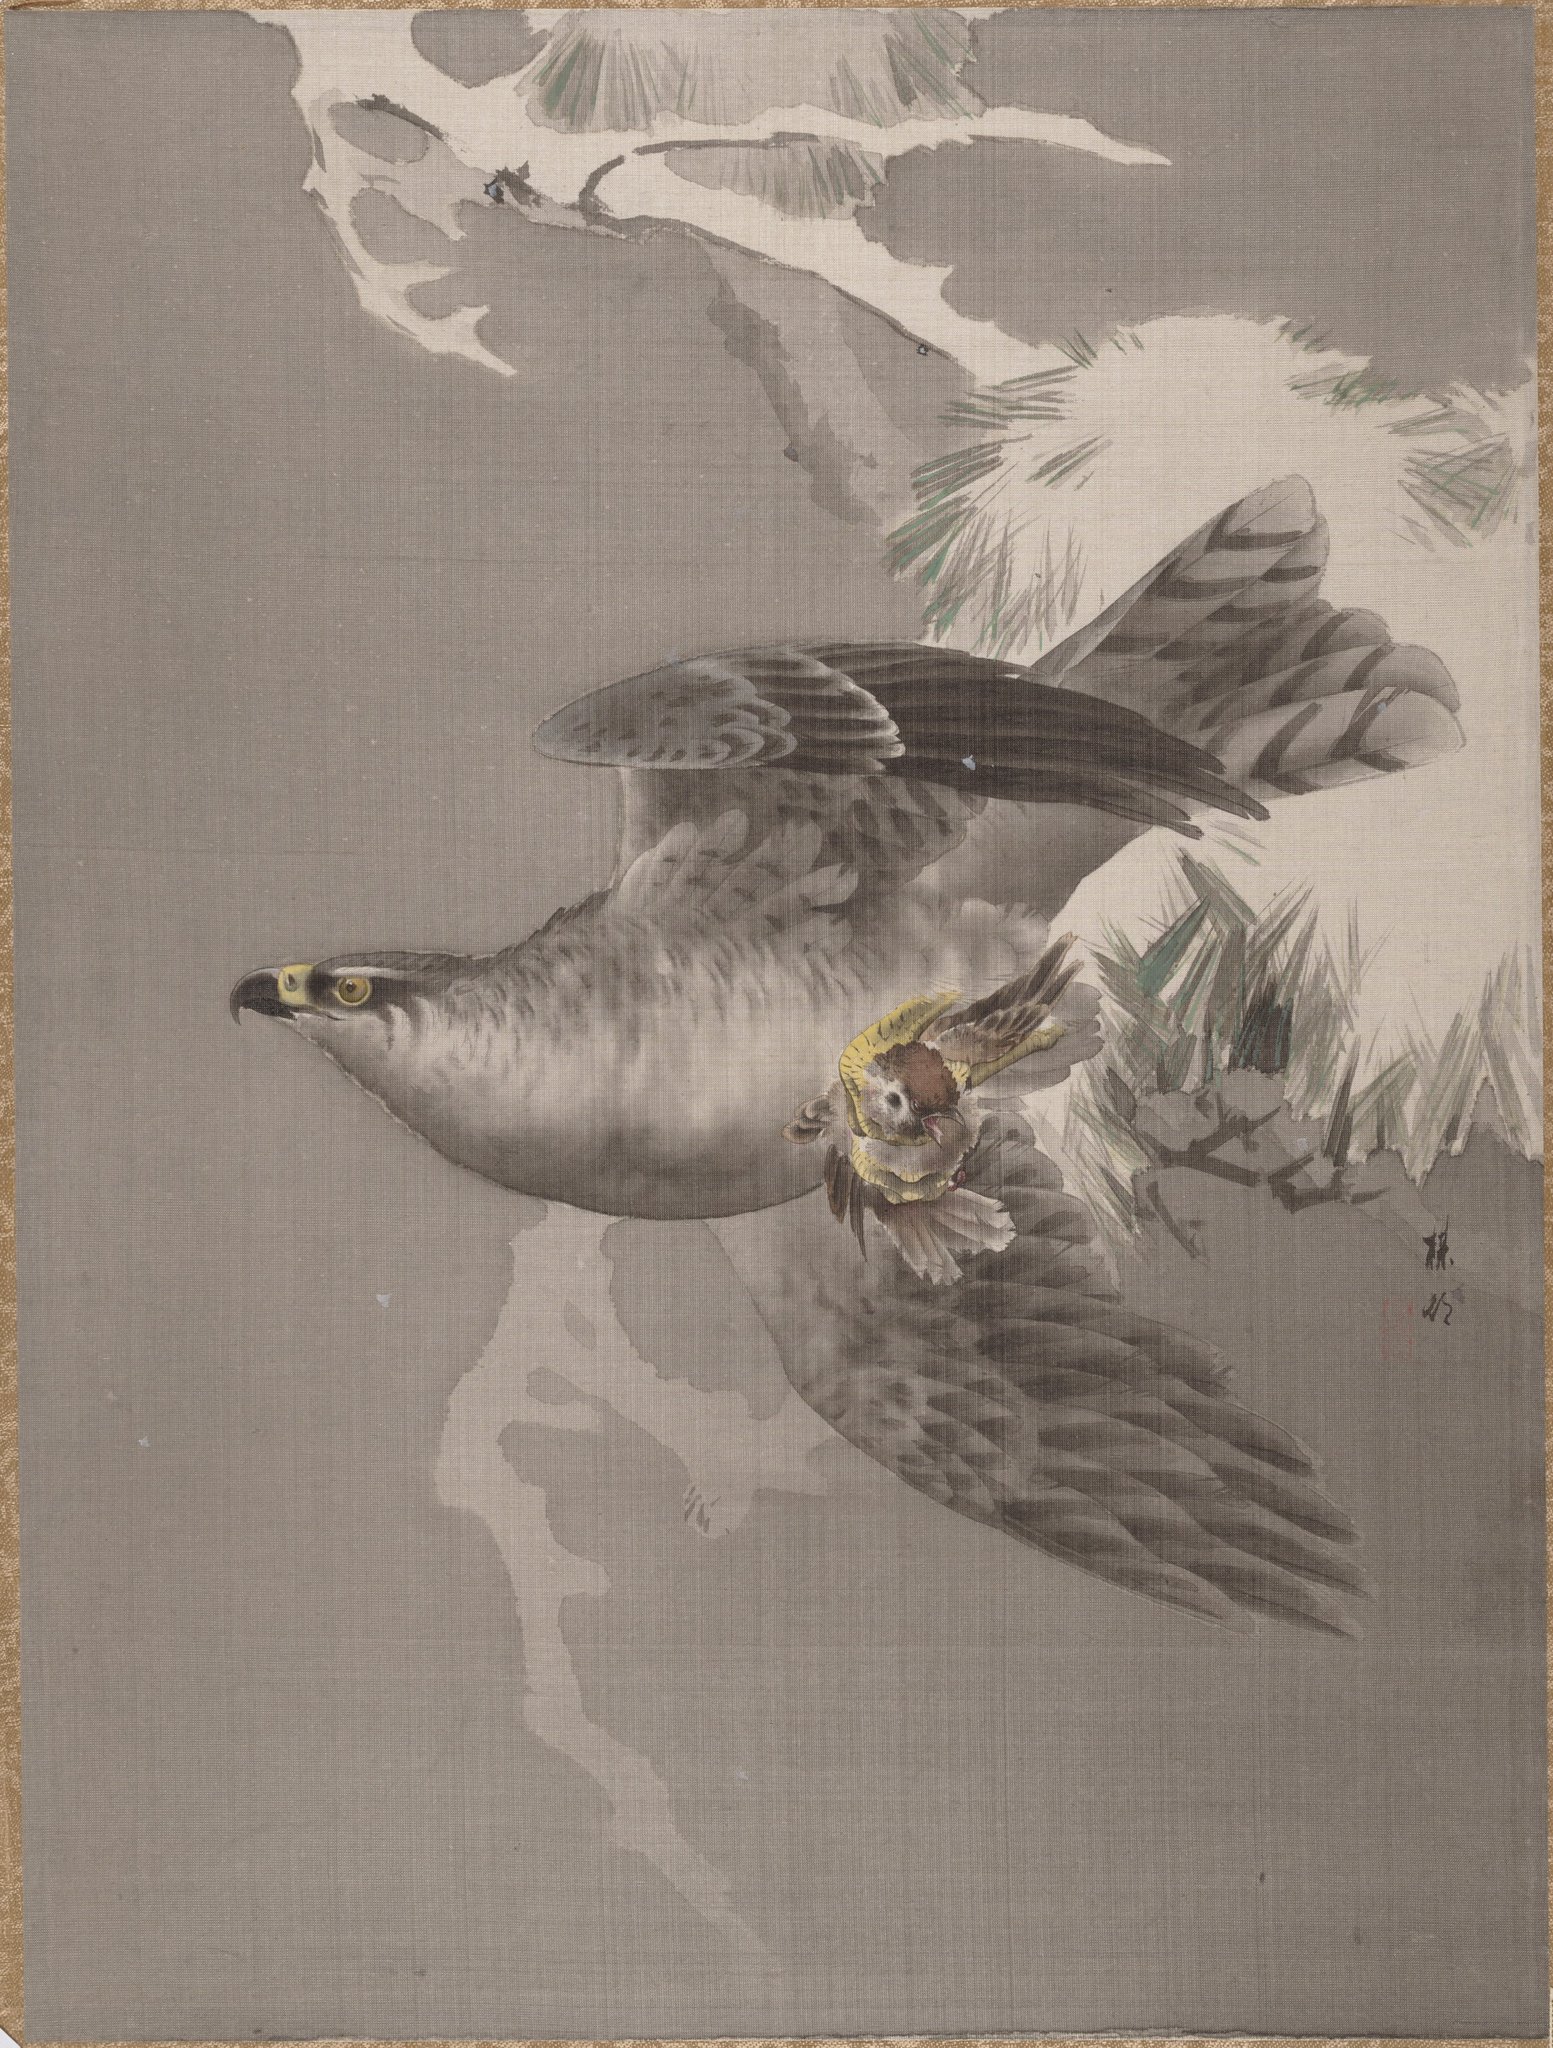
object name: album leaf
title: Hawk Holding a Small Bird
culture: japanese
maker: okada baison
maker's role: artist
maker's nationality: japanese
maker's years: 1864-1913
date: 1891-1892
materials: ink, silk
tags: birds,hawks